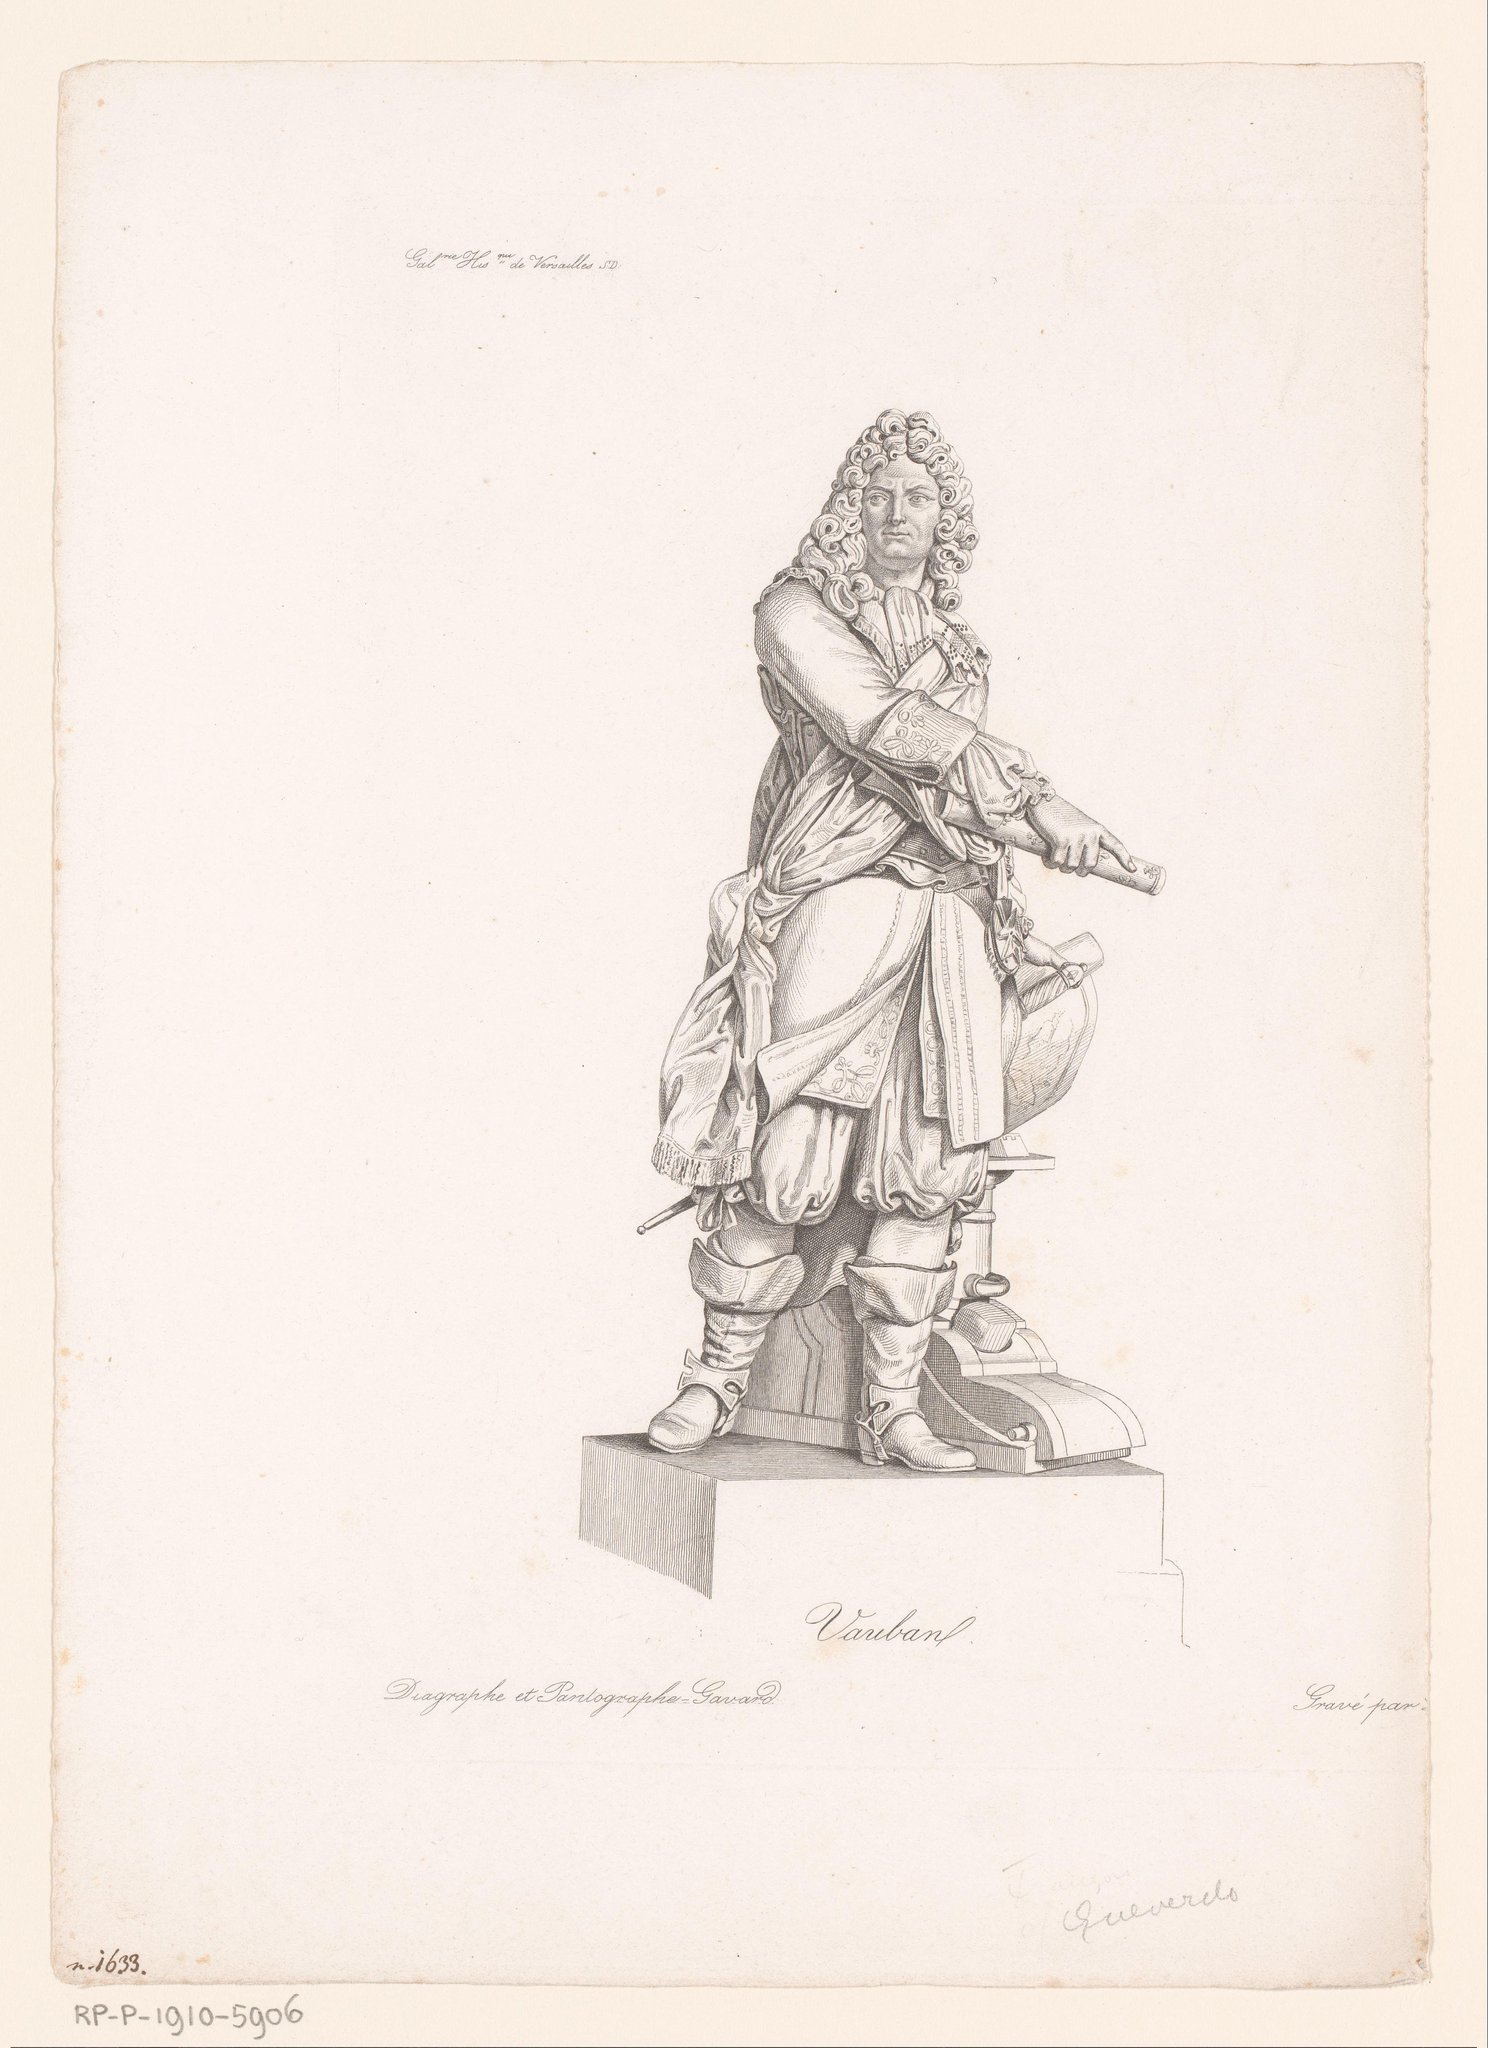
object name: print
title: Standbeeld van Sébastien Le Prestre de Vauban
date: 1838-1841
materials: paper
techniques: etching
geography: paris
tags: sébastien le prestre de vauban, commander-in-chief, general, marshal, historical persons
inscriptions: collector's mark: Lugt 2228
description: Prent uit: Galeries historiques de Versailles. Parijs: Charles Gavard, 1838-1841.